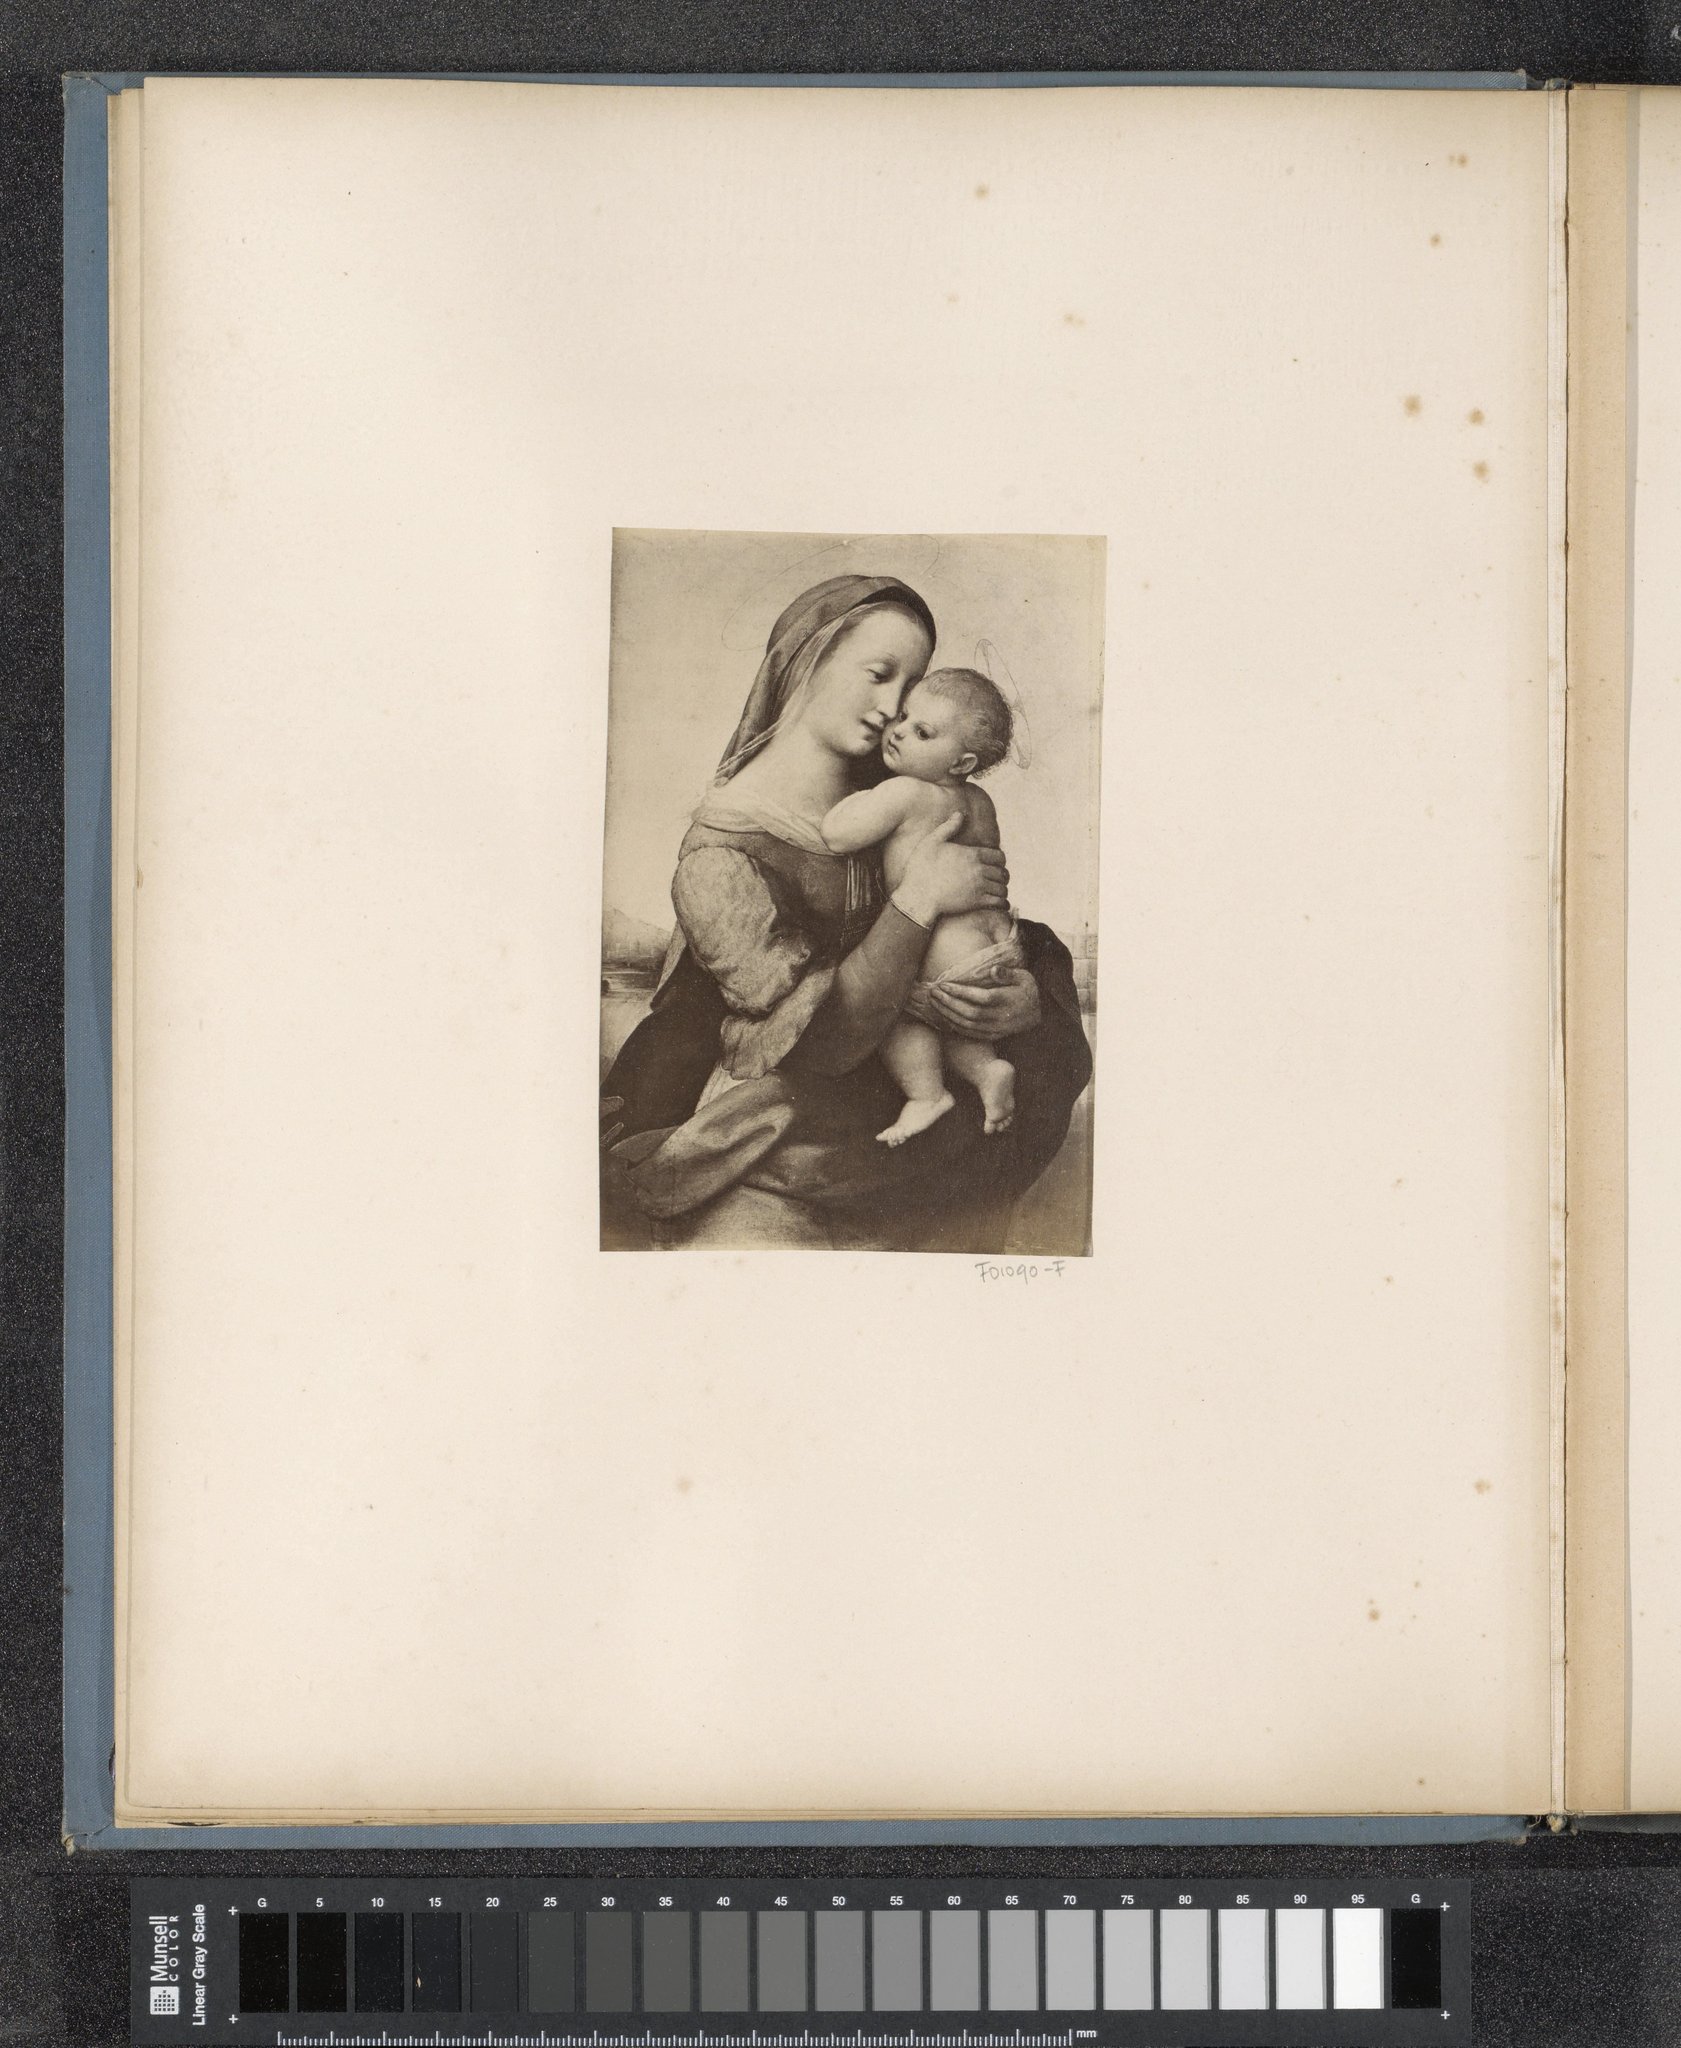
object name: reproduction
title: Fotoreproductie van (vermoedelijk) een prent naar een schilderij door Rafael, voorstellend Maria met Kind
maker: Anonymous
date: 1870-1900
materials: paper, photographic support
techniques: albumen print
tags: madonna: i.e. mary with the christ-child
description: Onderdeel van Reisalbum met foto's van bezienswaardigheden in Duitsland en Oostenrijk en van kunstwerken.